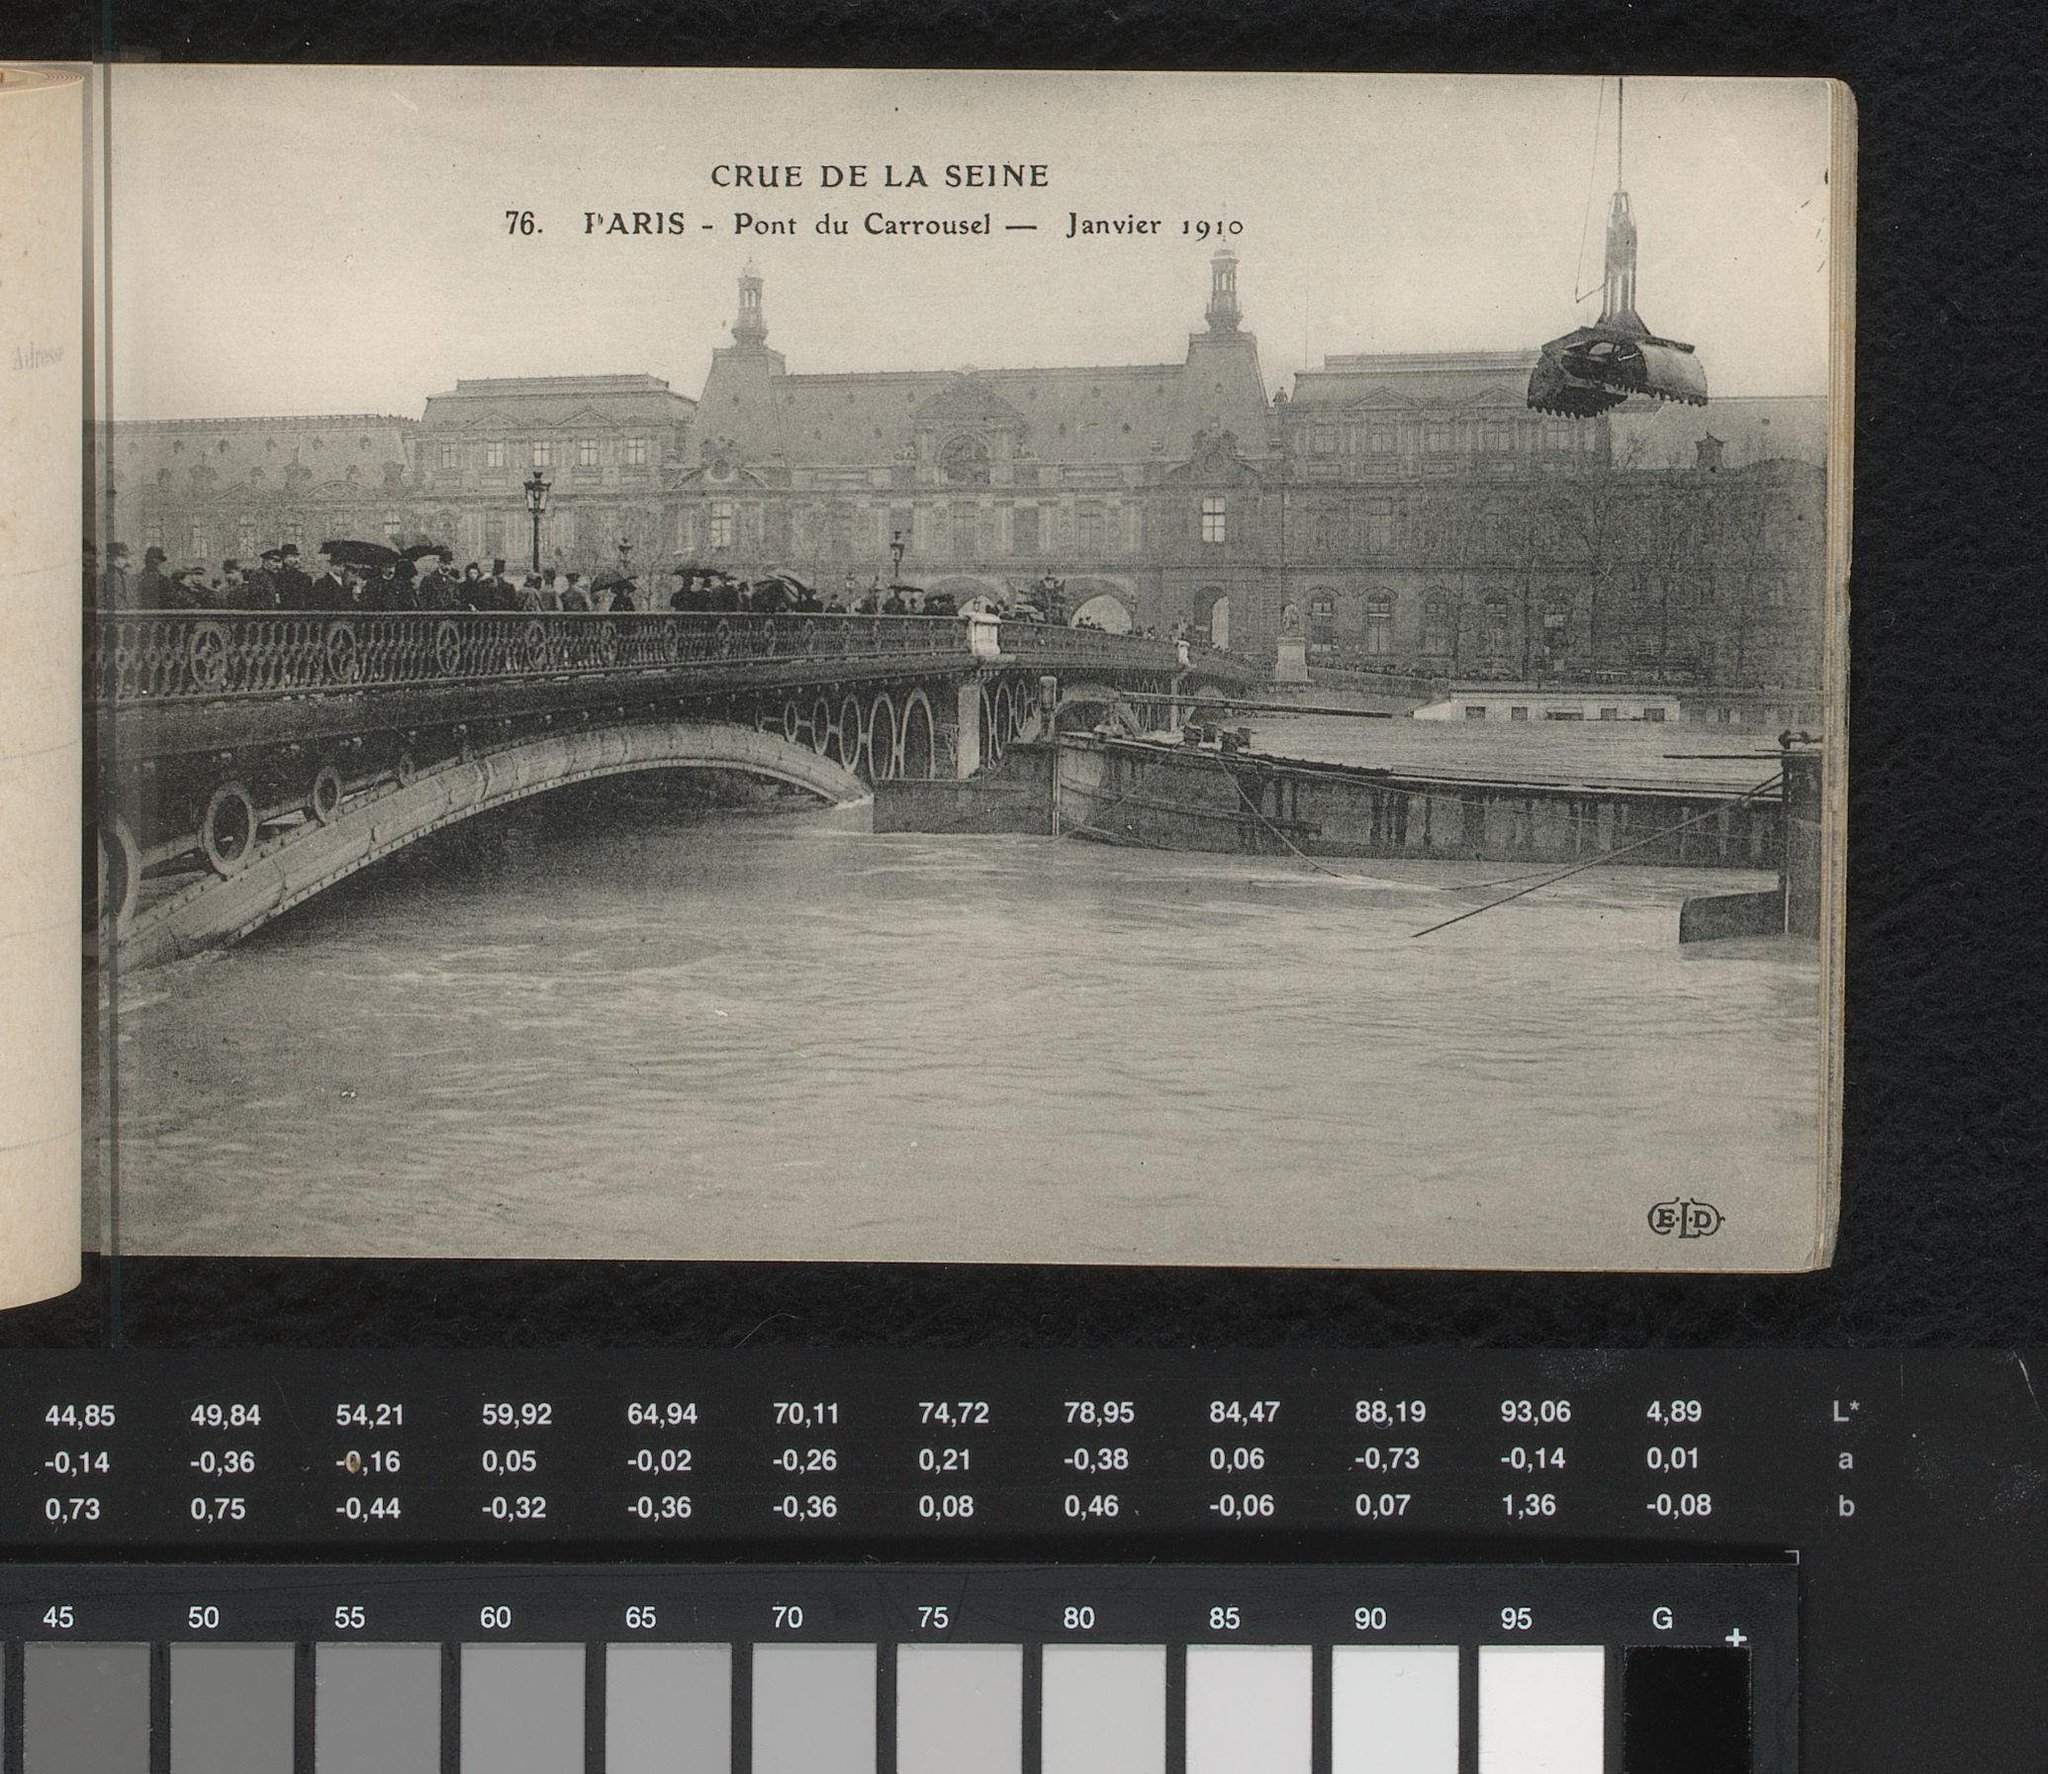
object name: ansichtkaart, prentbriefkaart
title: Paris. Pont du Carrousel. Janvier 1910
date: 1910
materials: cardboard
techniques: photograph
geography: paris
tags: flood, bridge, city-view, and landscape with man-made constructions (+ city(-scape) with figures, staffage)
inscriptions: date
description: Prentbriefkaart maakt deel uit van een album.